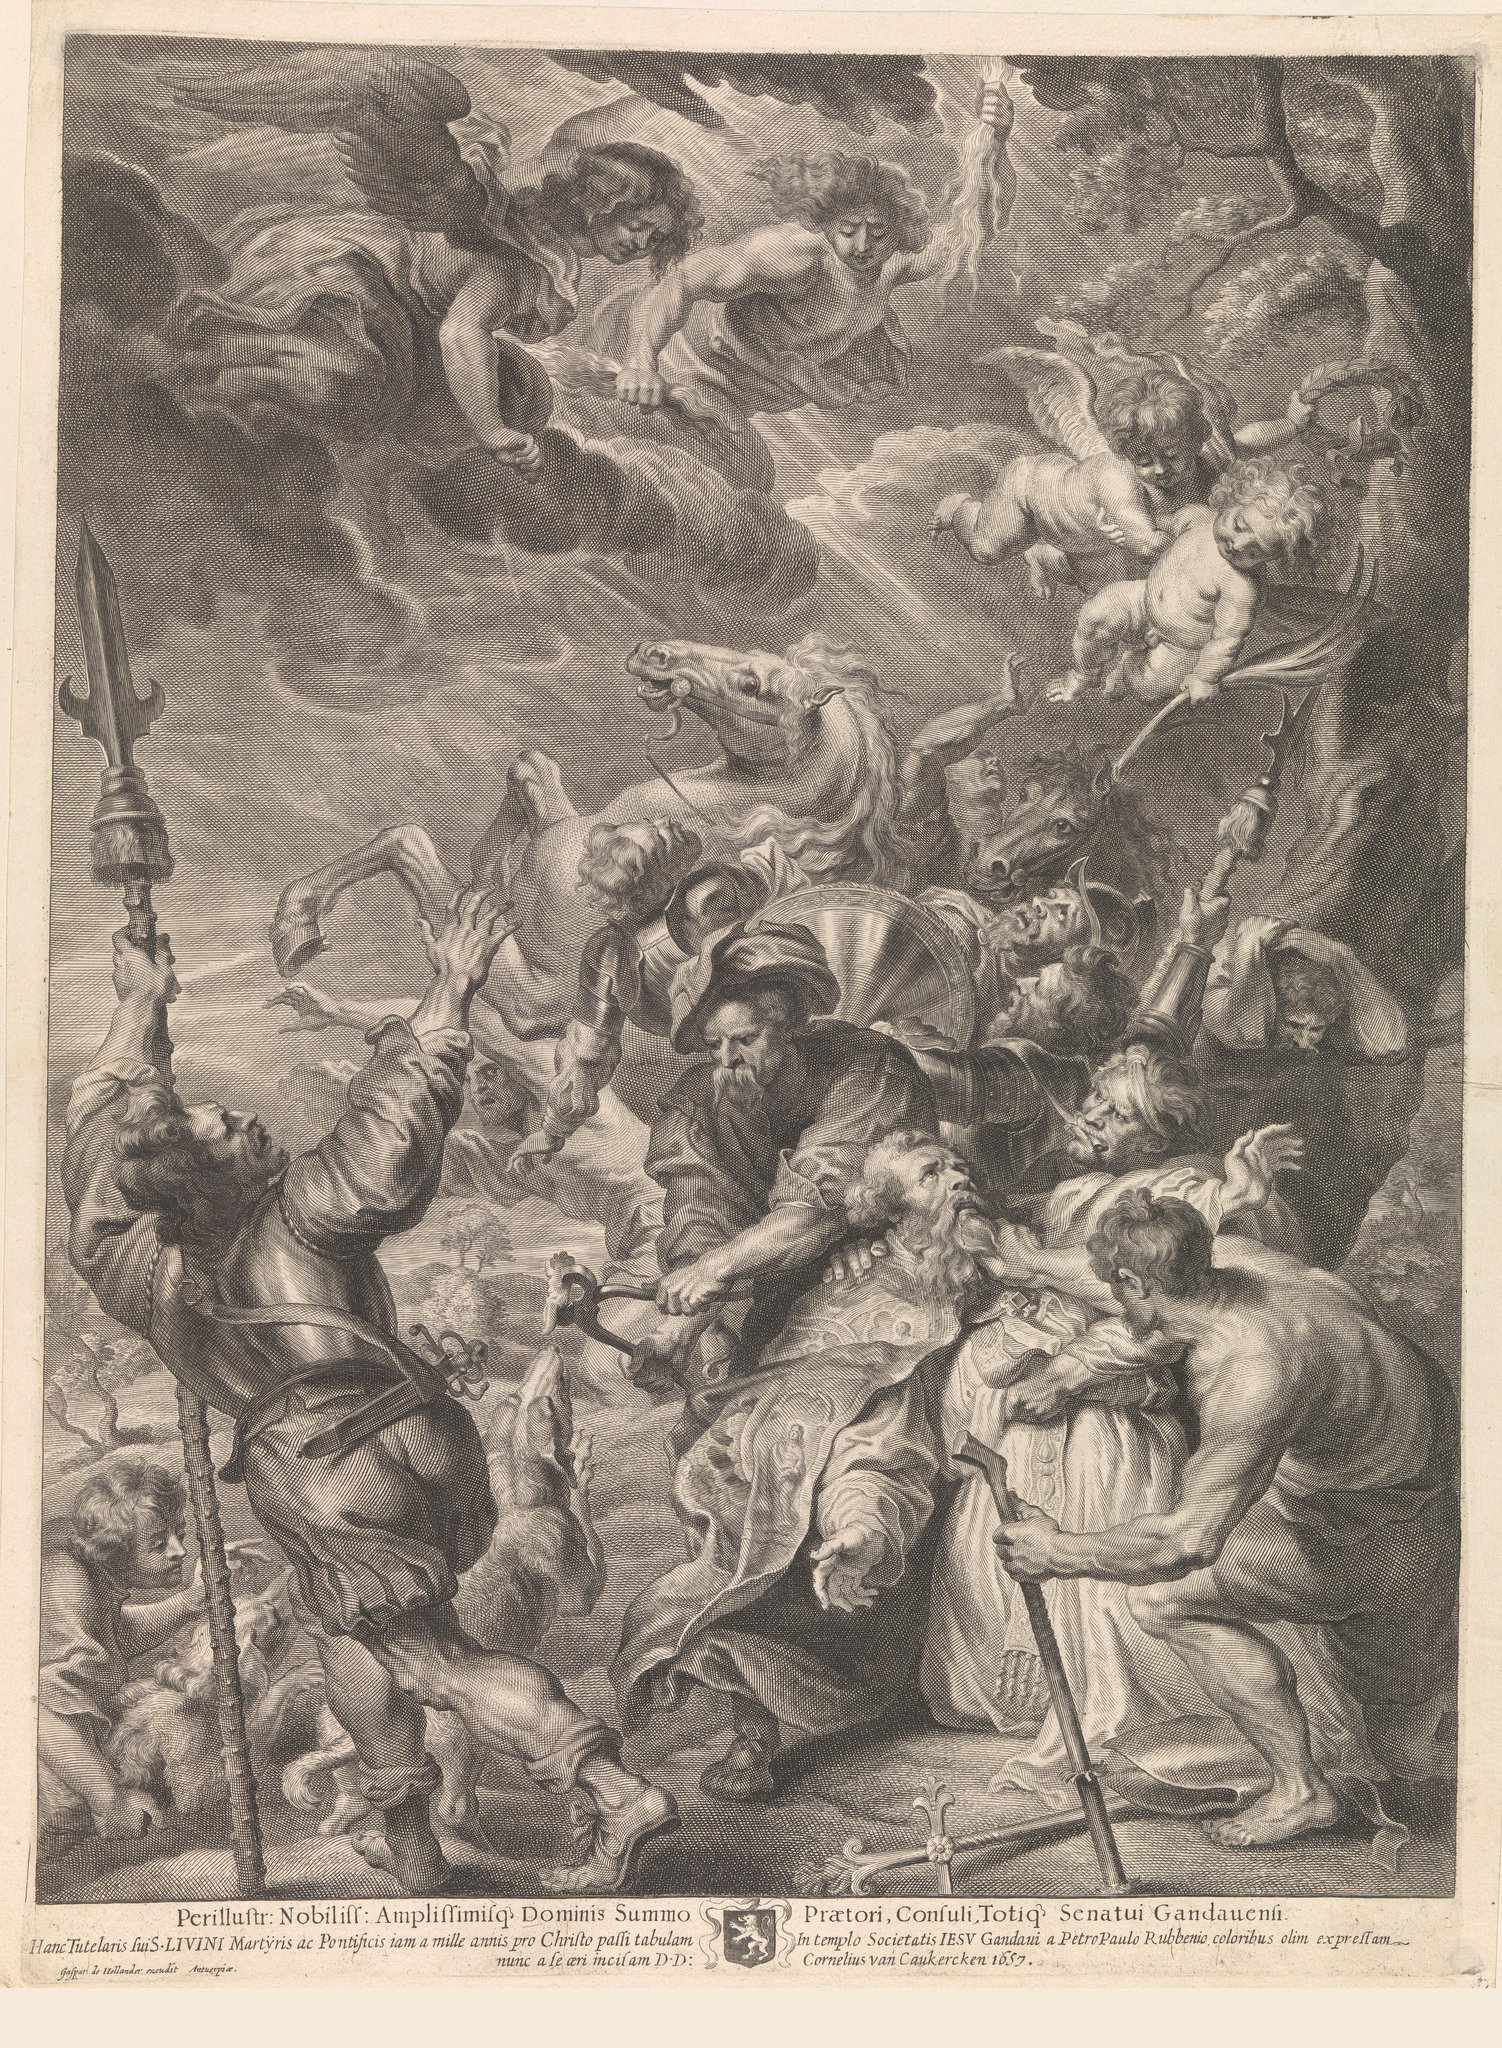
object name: album leaf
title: Martelaarschap van de H. Livinus van Gent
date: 1657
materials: paper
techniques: engraving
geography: southern netherlands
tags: martyrdom, suffering, misfortune, death of st. livinus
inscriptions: date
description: De tong van de heilige Livinus is uitgerukt. Een beul houdt hem bij de baard vast, een andere man houdt de tang met de tong vast en voert deze aan een hond. Het paard op de achtergrond en de soldaten schrikken als aan de hemel engelen verschijnen en een mannelijke figuur het laat bliksemen. Midden onder een opdracht in het Latijn aan en een wapenschild. Deze prent maakt deel uit van een album.